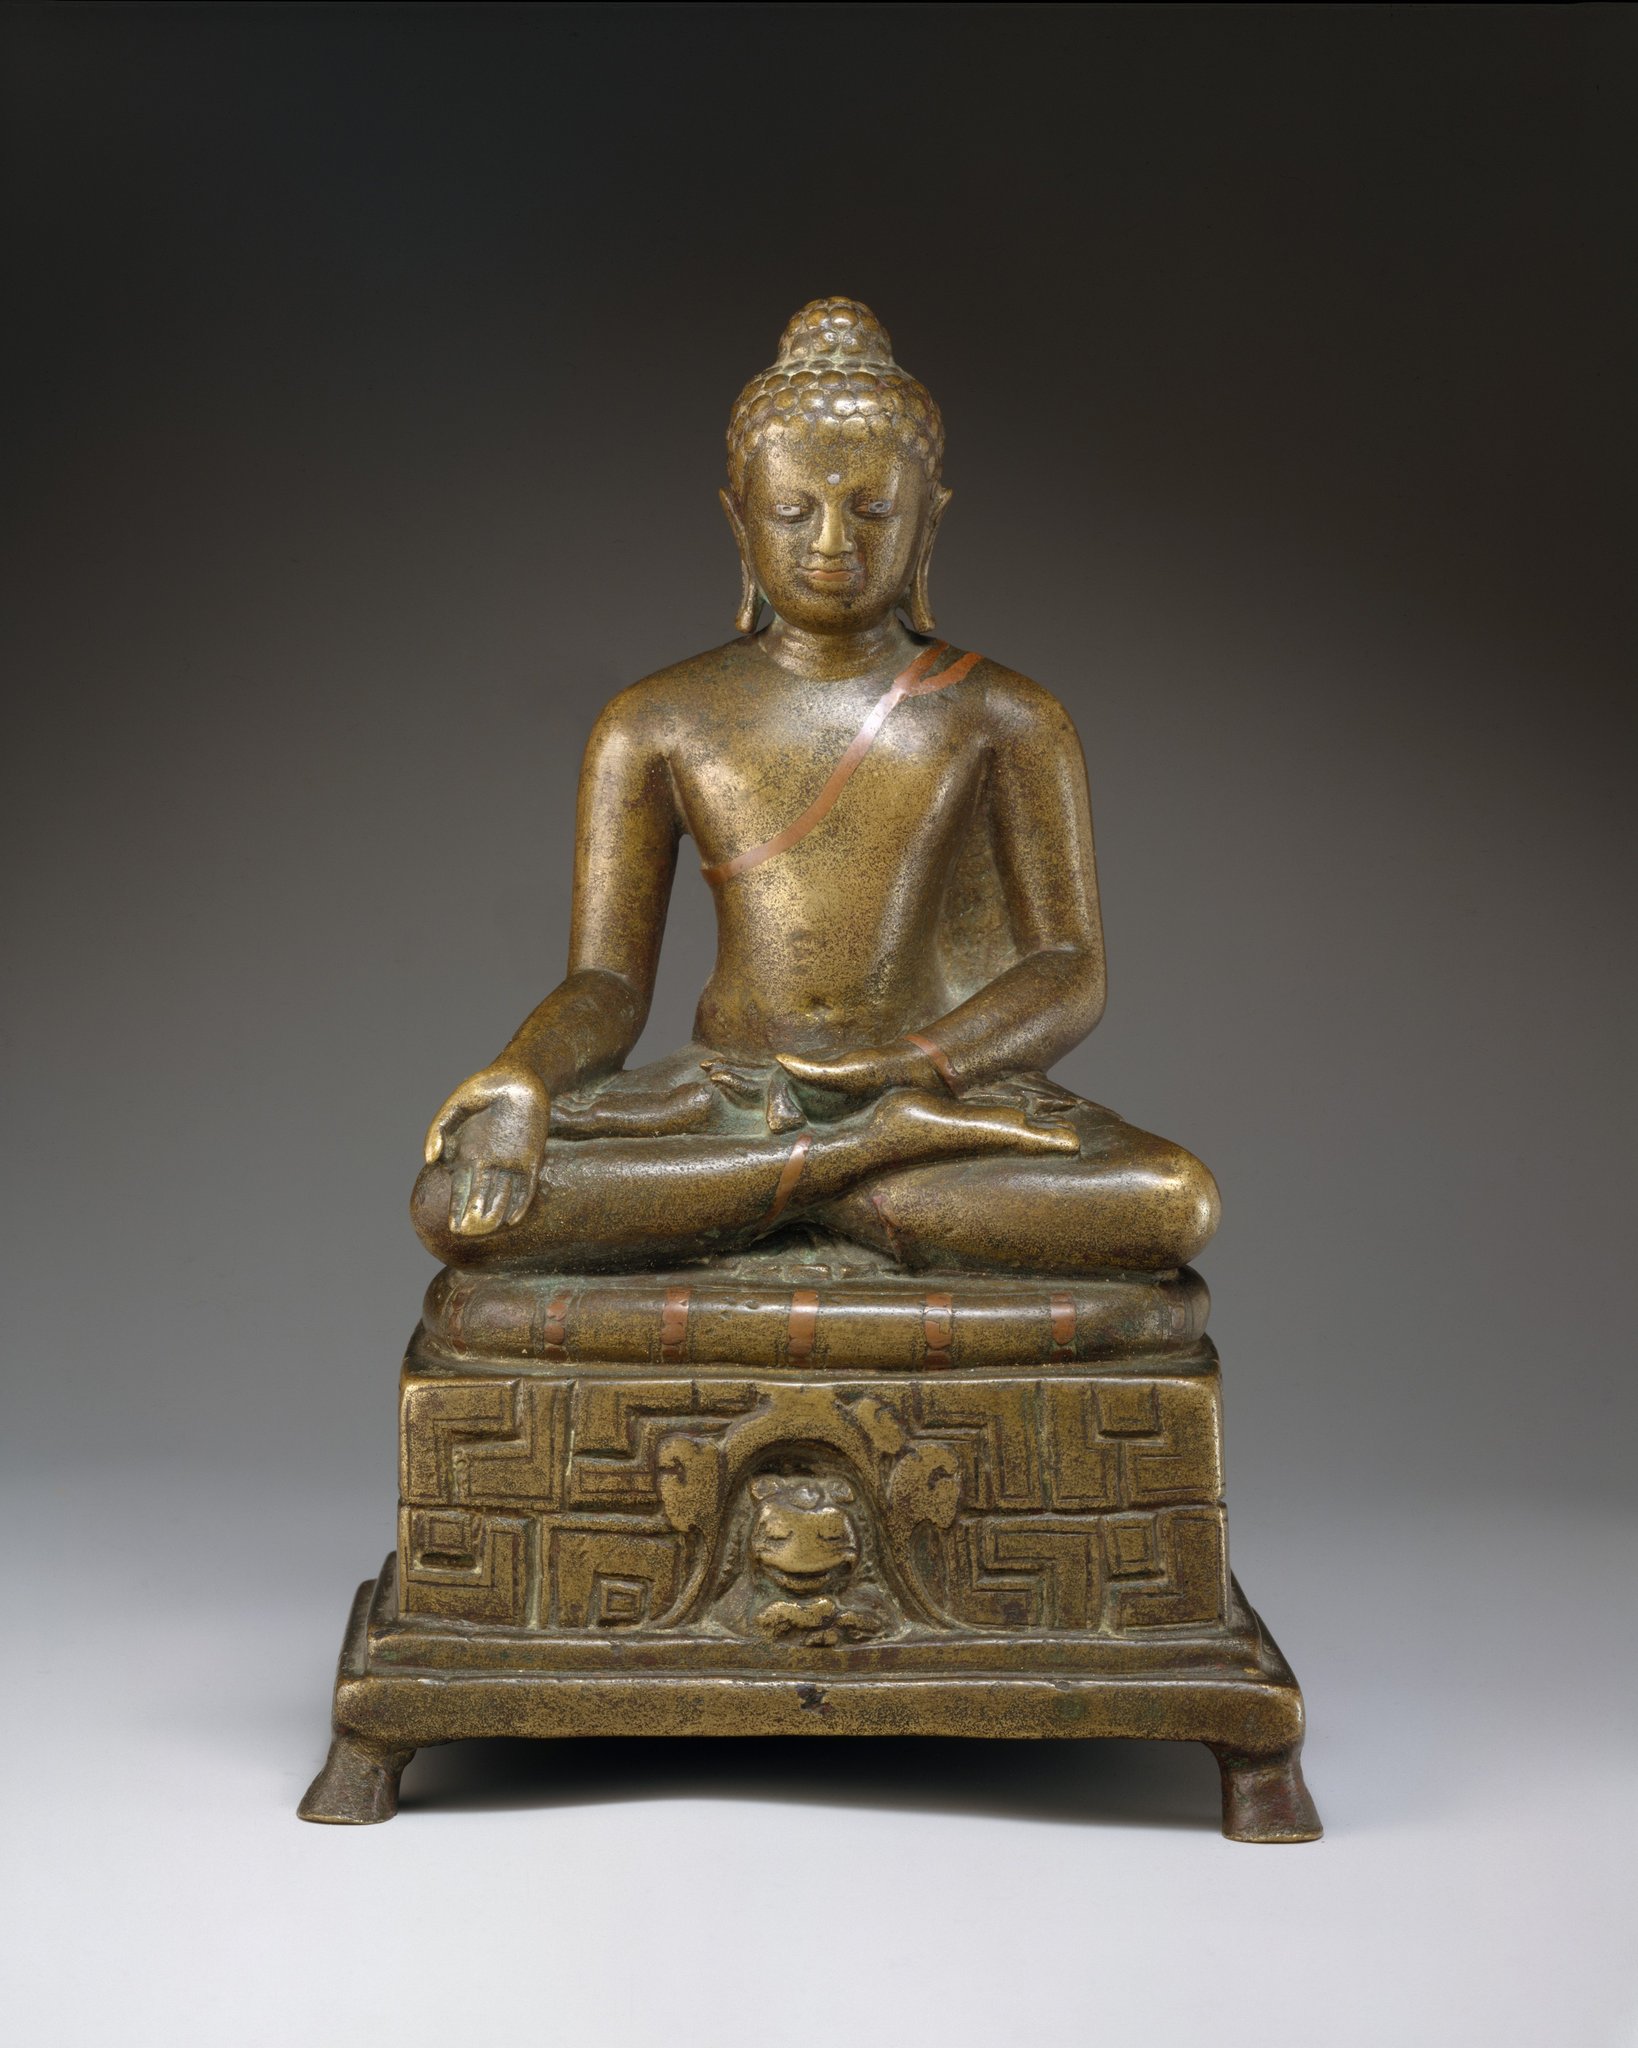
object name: figure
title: Seated Buddha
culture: indian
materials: bronze, copper, silver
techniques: inlay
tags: post-gupta,buddha